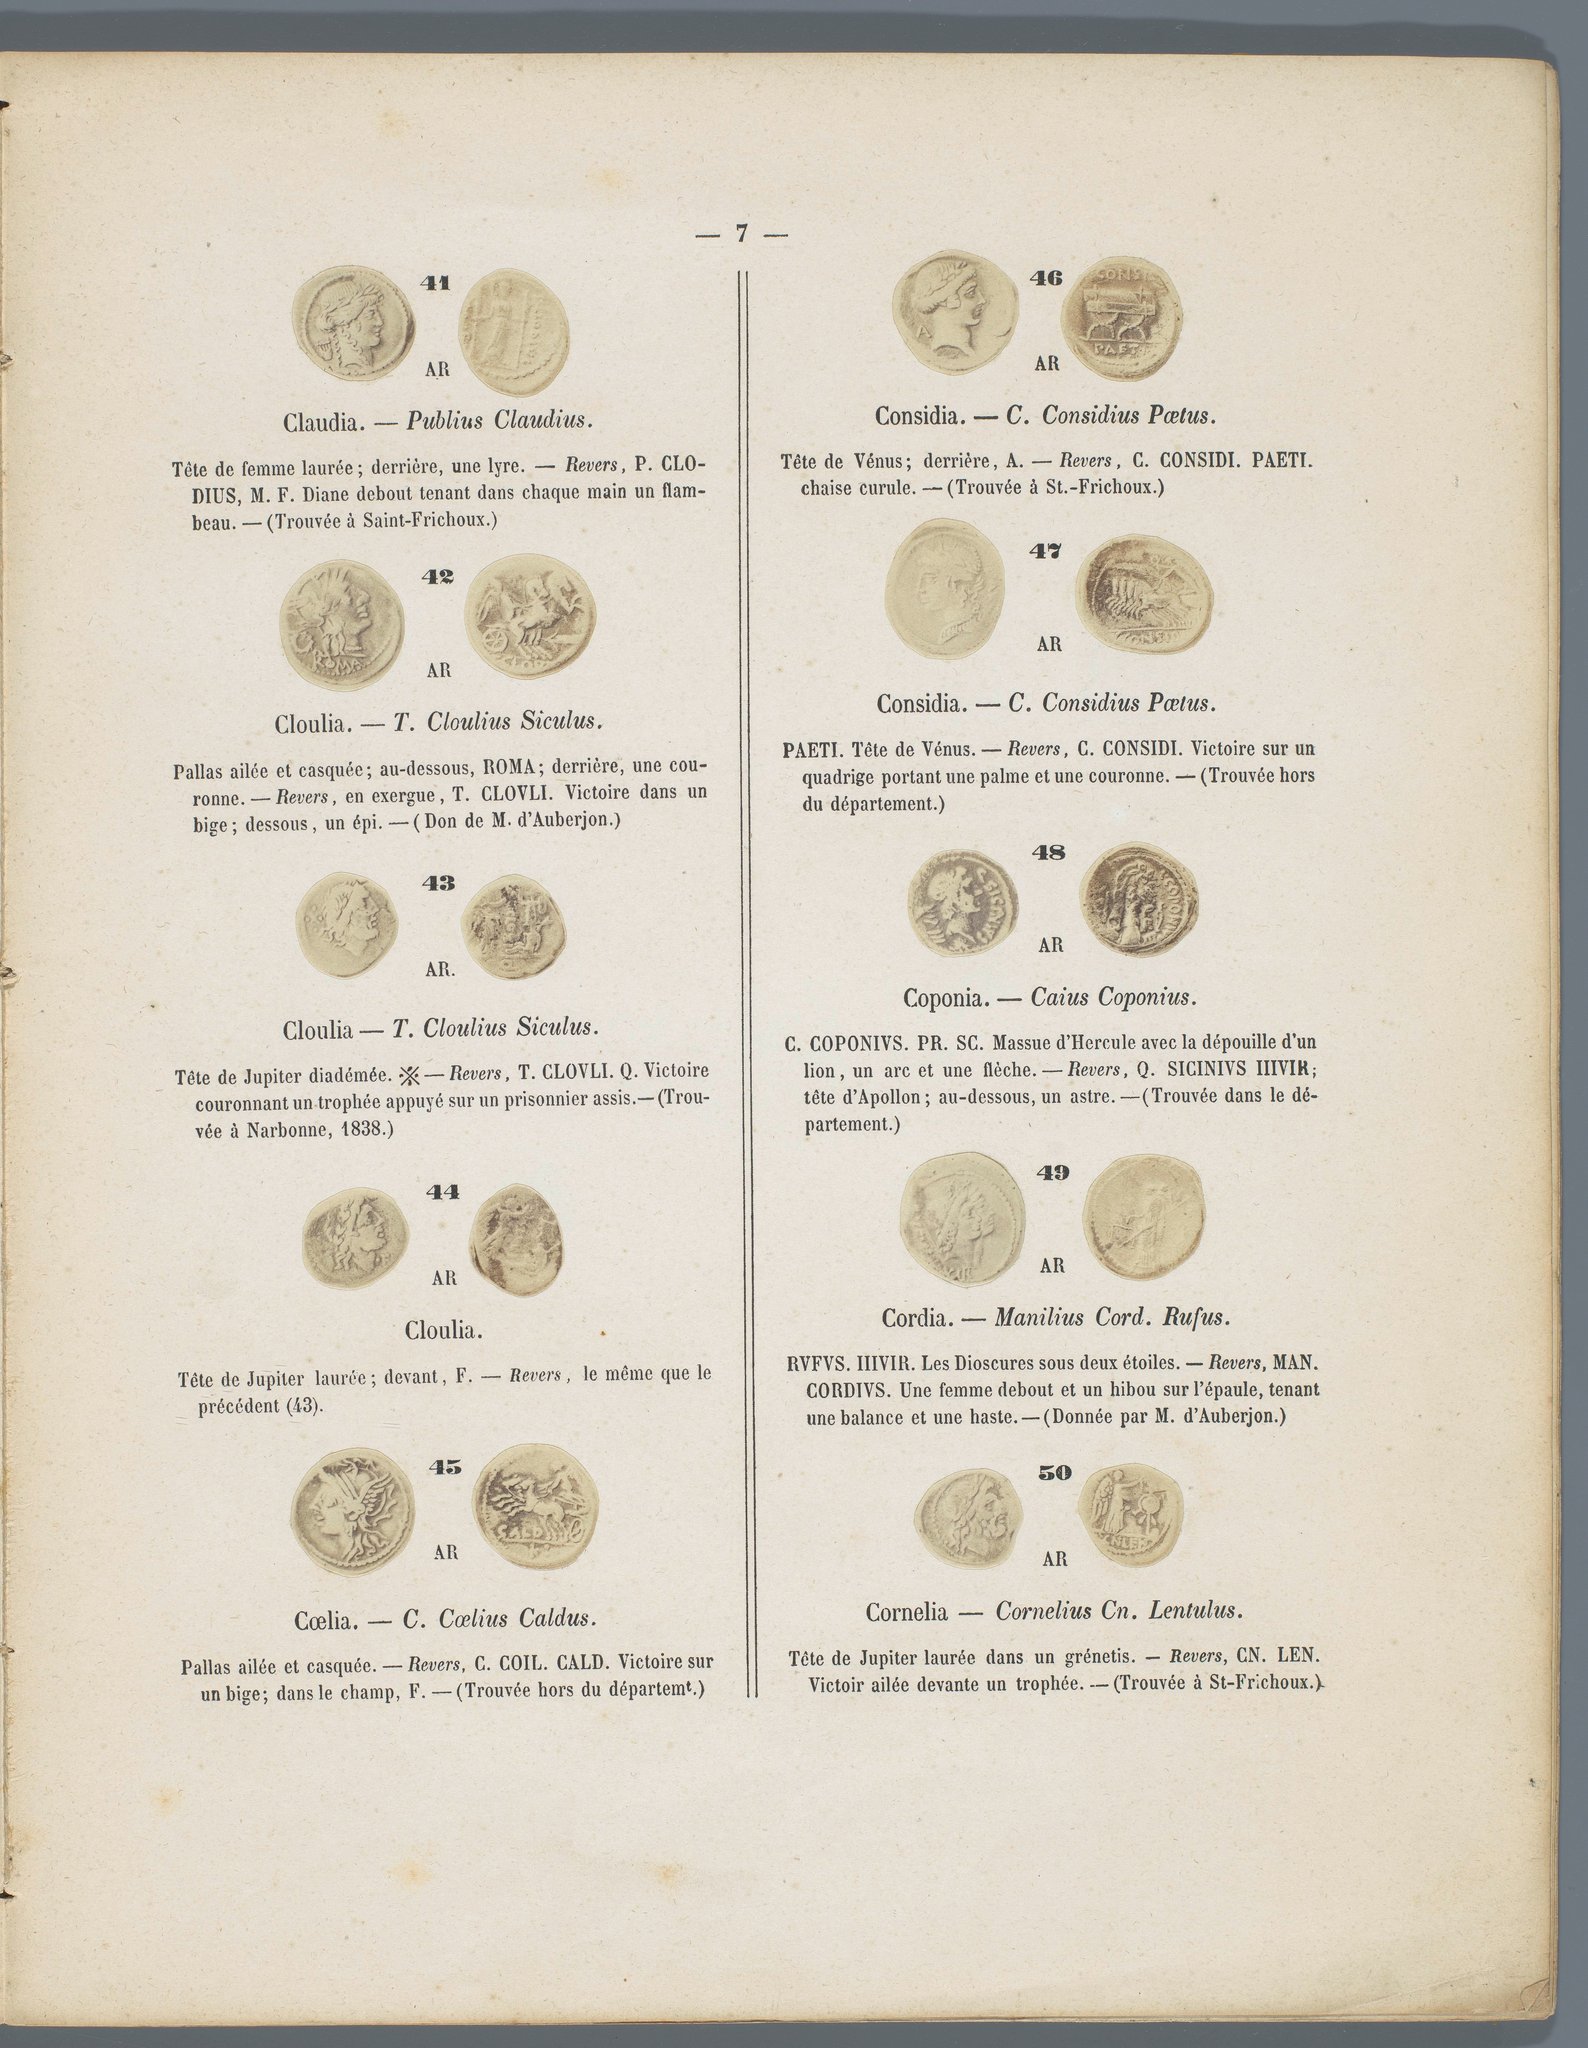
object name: page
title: Tien Romeinse munten, gezien van voor- en achterkant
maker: léopold verguet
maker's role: abt, fotograaf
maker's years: 1817-1914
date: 1854-1864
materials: photographic support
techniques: albumen print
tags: coin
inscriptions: number